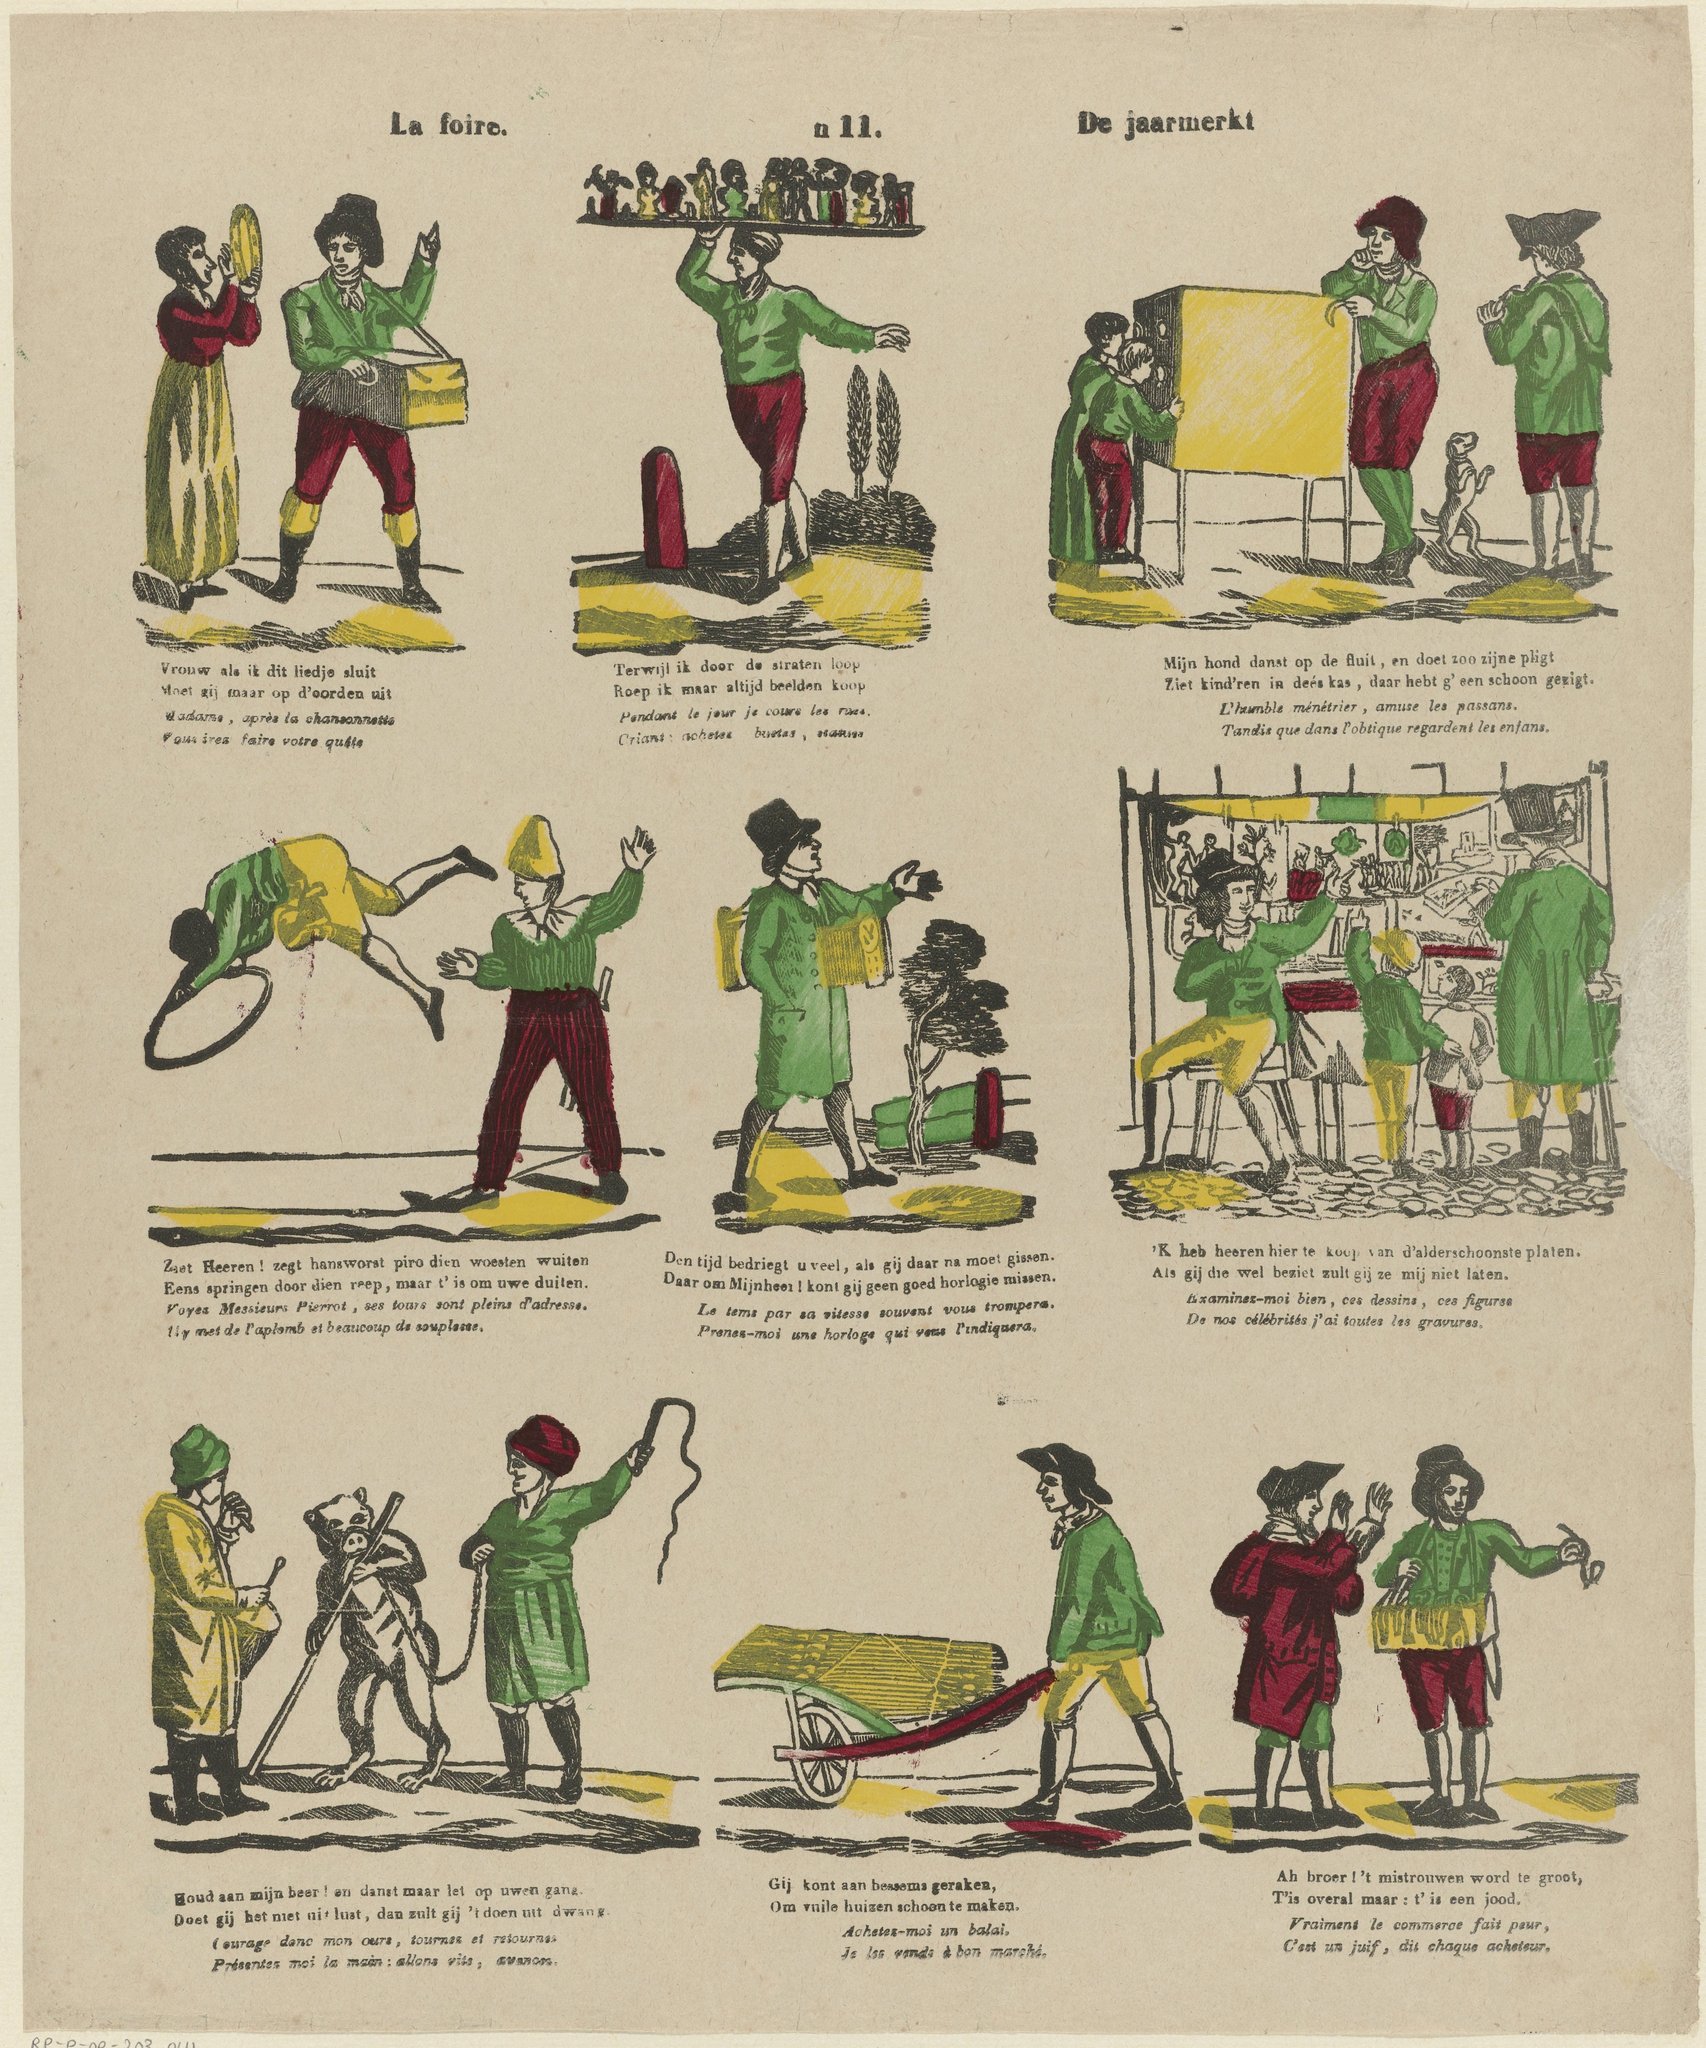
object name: print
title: La foire / De jaarmarkt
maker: Anonymous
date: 1833-1900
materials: paper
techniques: colour, letterpress printing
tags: taming and training of animals, street-trader, pleasure fair and circus, merchant, salesman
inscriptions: collector's mark: Lugt 2760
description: Blad met 9 voorstellingen van artiesten en verkopers op de jaarmarkt, waaronder een beeldenverkoper en een berentemmer. Onder elke afbeelding een tweeregelig vers in het Nederlands en in het Frans. Genummerd midden boven: n 11.